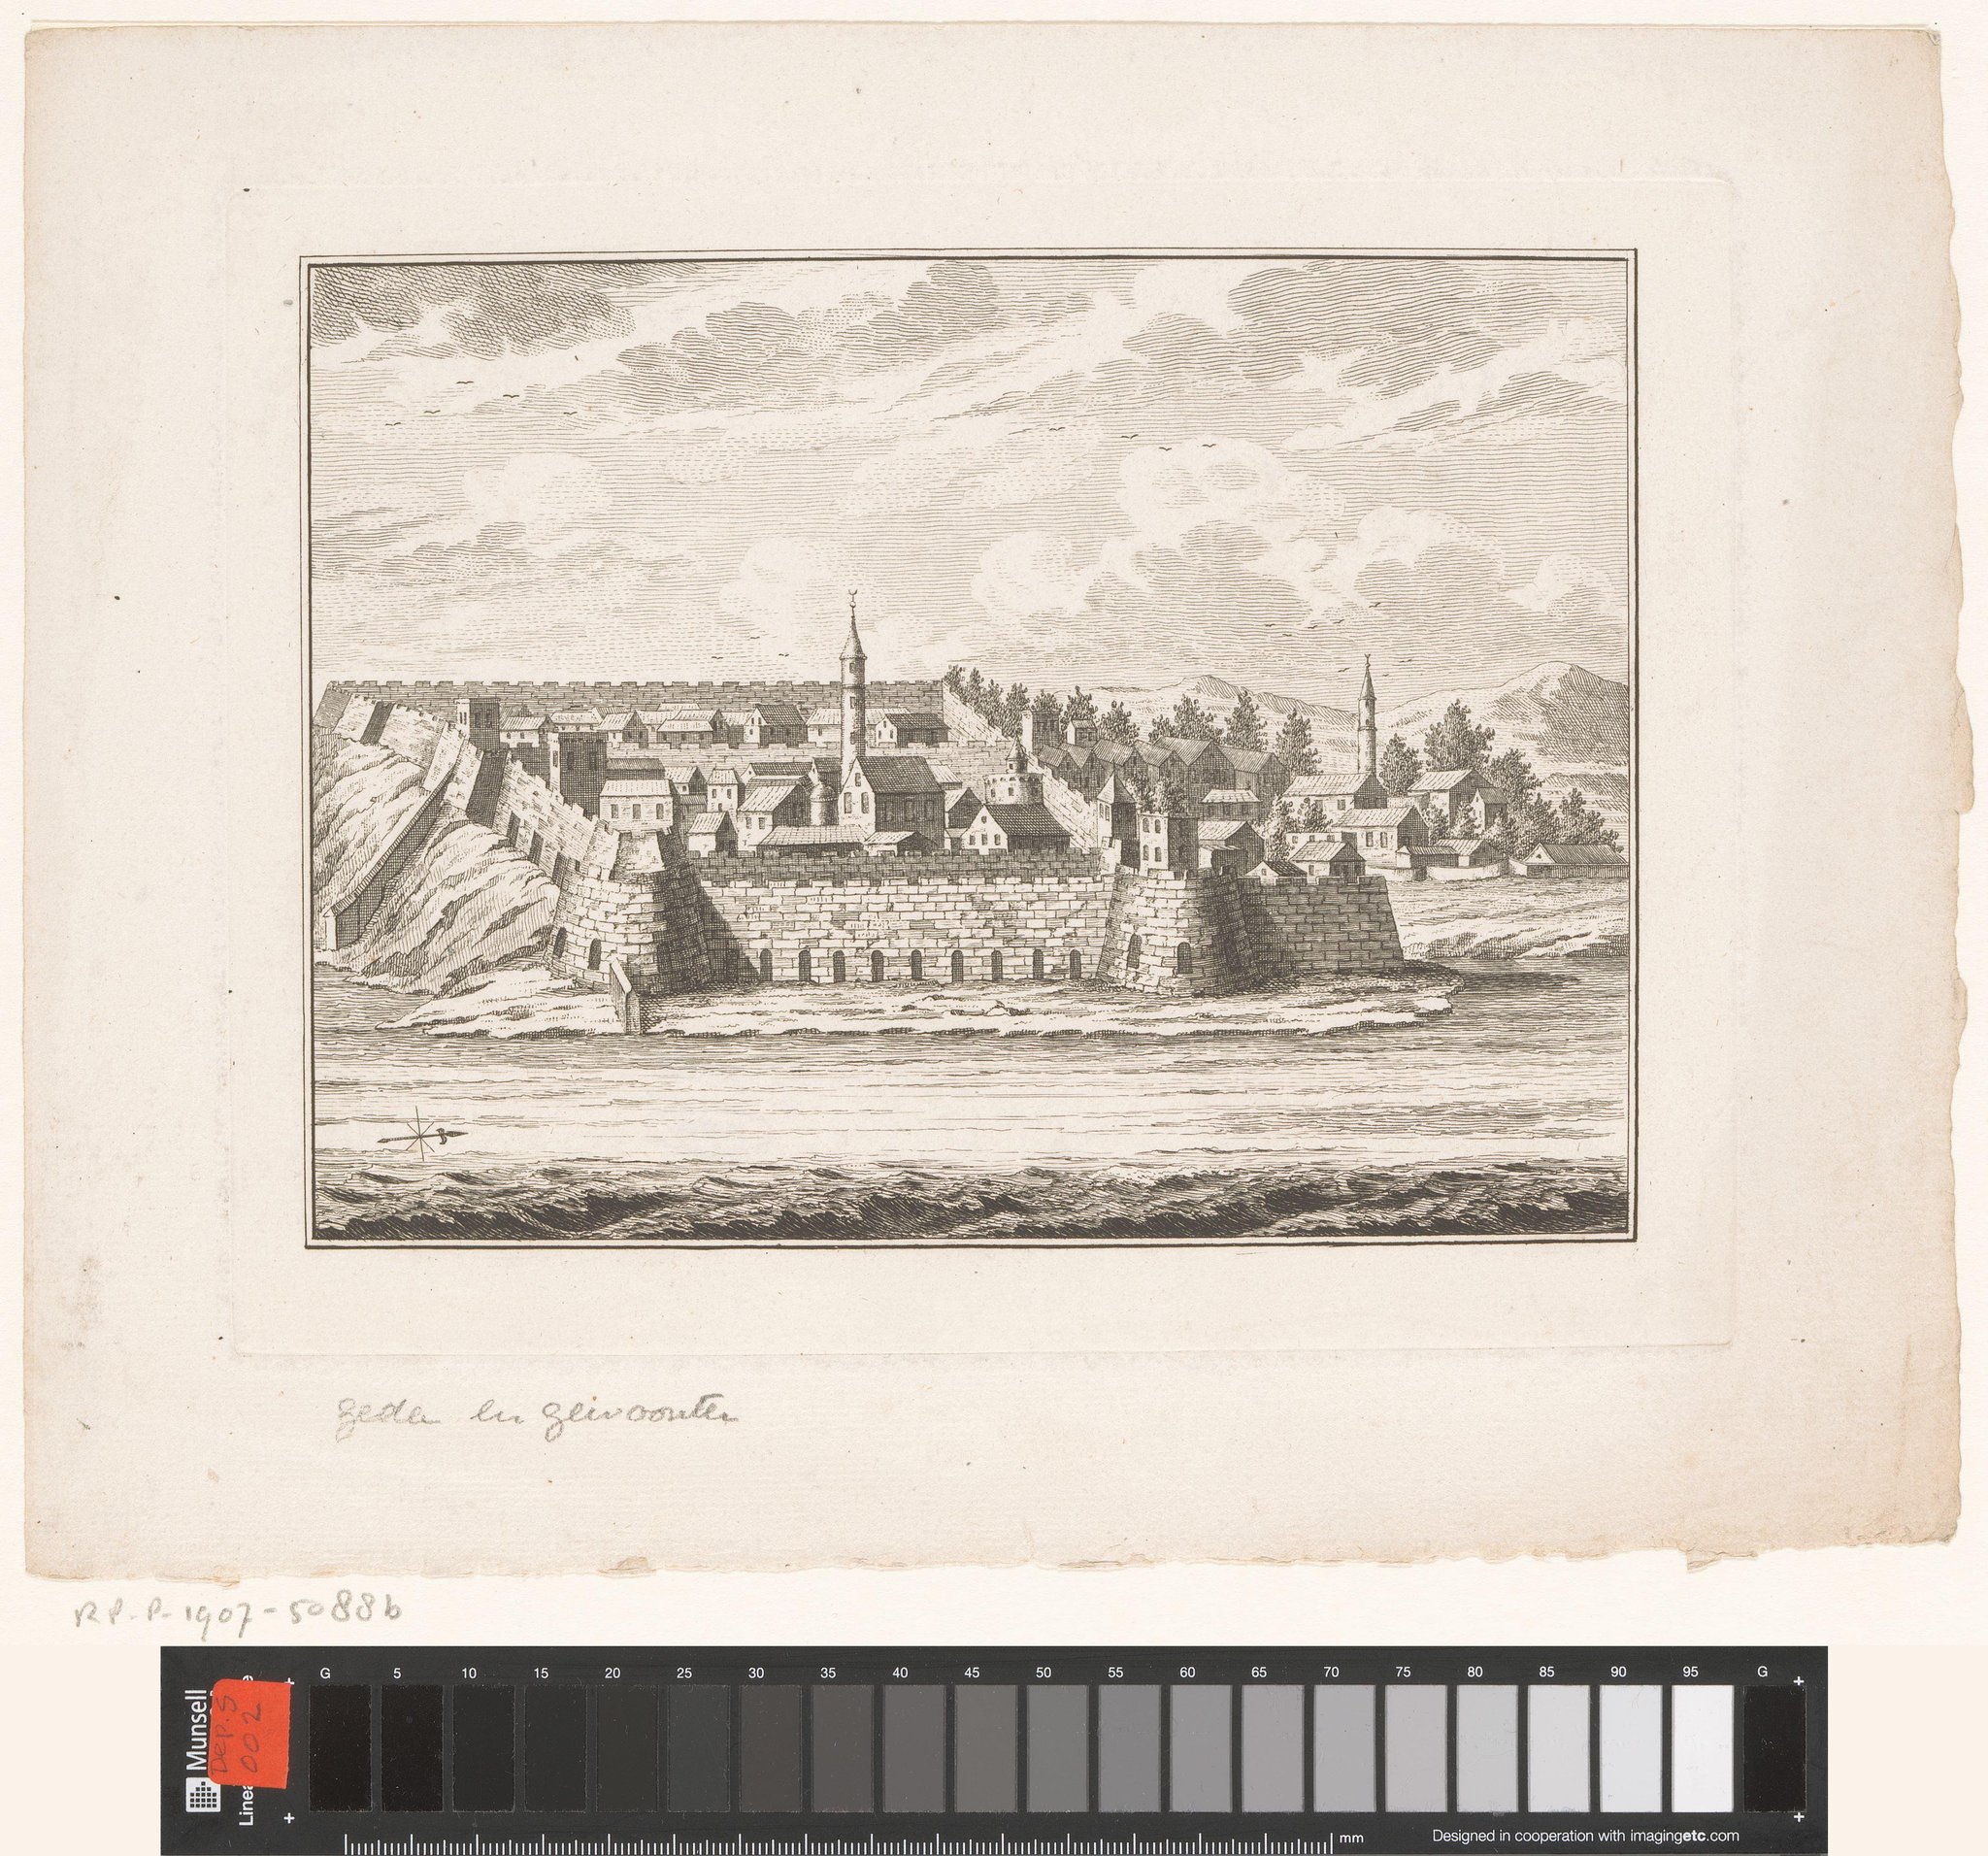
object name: print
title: Gezicht op een vestingstad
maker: Anonymous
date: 1600-1699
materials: paper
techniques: etching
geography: netherlands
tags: prospect of city, town panorama, silhouette of city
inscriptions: collector's mark: Lugt 2228